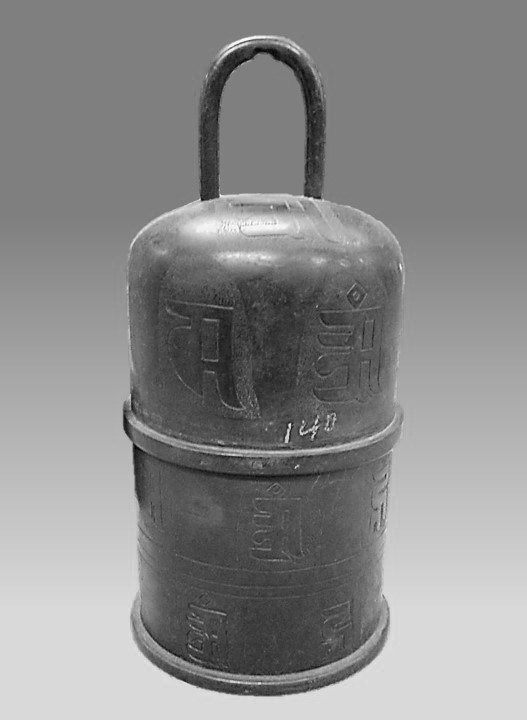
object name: bell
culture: chinese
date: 1867-1900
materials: metal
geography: china